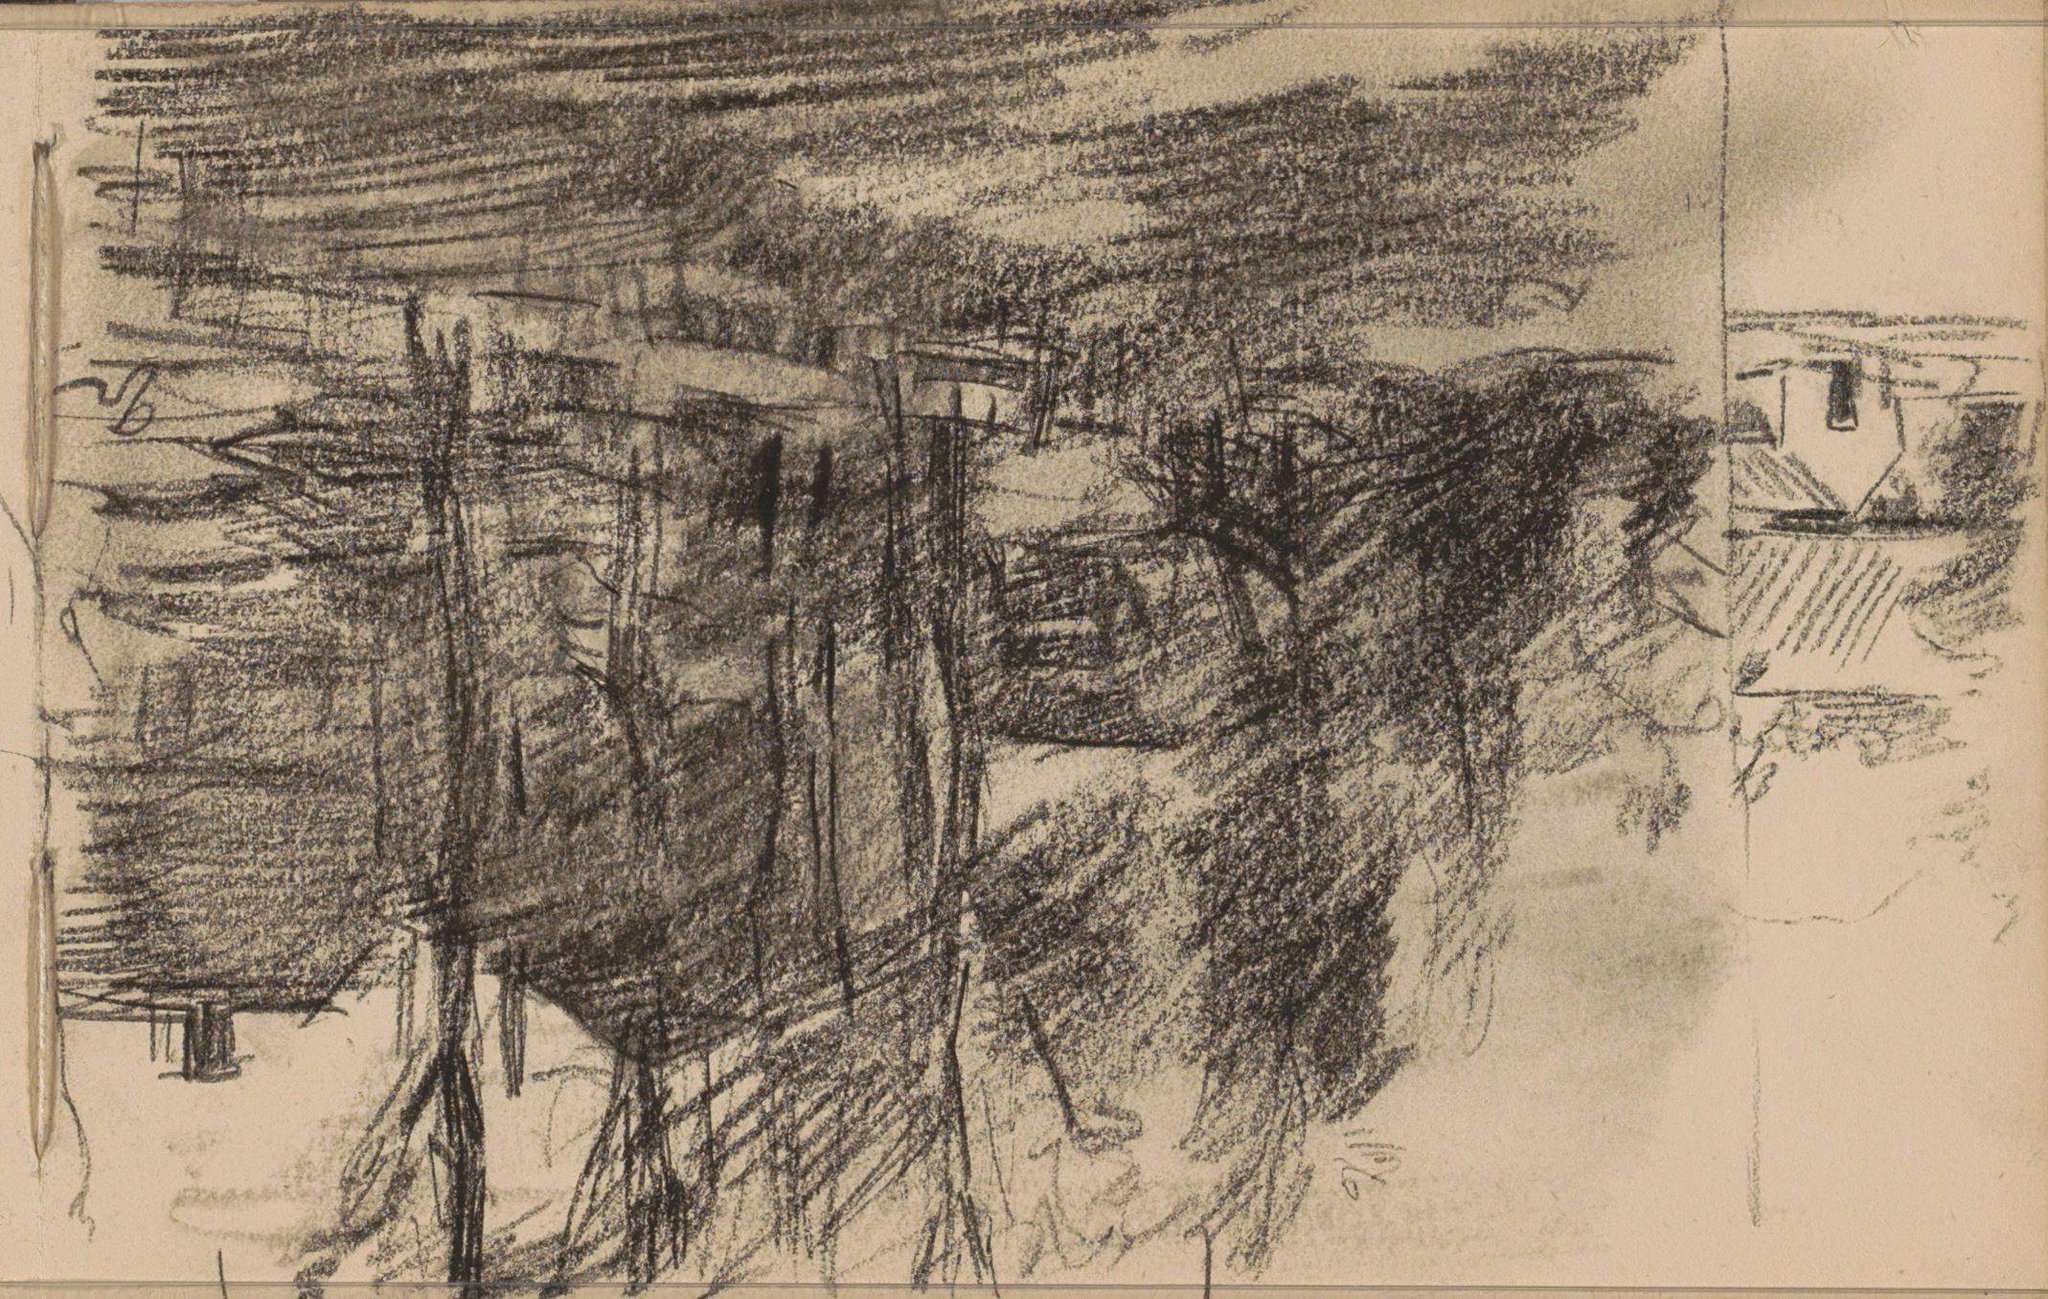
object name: sketchbook leaf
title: Landschap met bebouwing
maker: johan antonie de jonge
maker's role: draughtsman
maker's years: 1864-1927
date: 1909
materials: chalk, paper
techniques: stumping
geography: south holland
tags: landscapes, rural housing, e.g. country-house, villa, cottage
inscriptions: kleurnotitie, handgeschreven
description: Landschap met bebouwing. Blad 23 uit een schetsboek met 31 bladen.